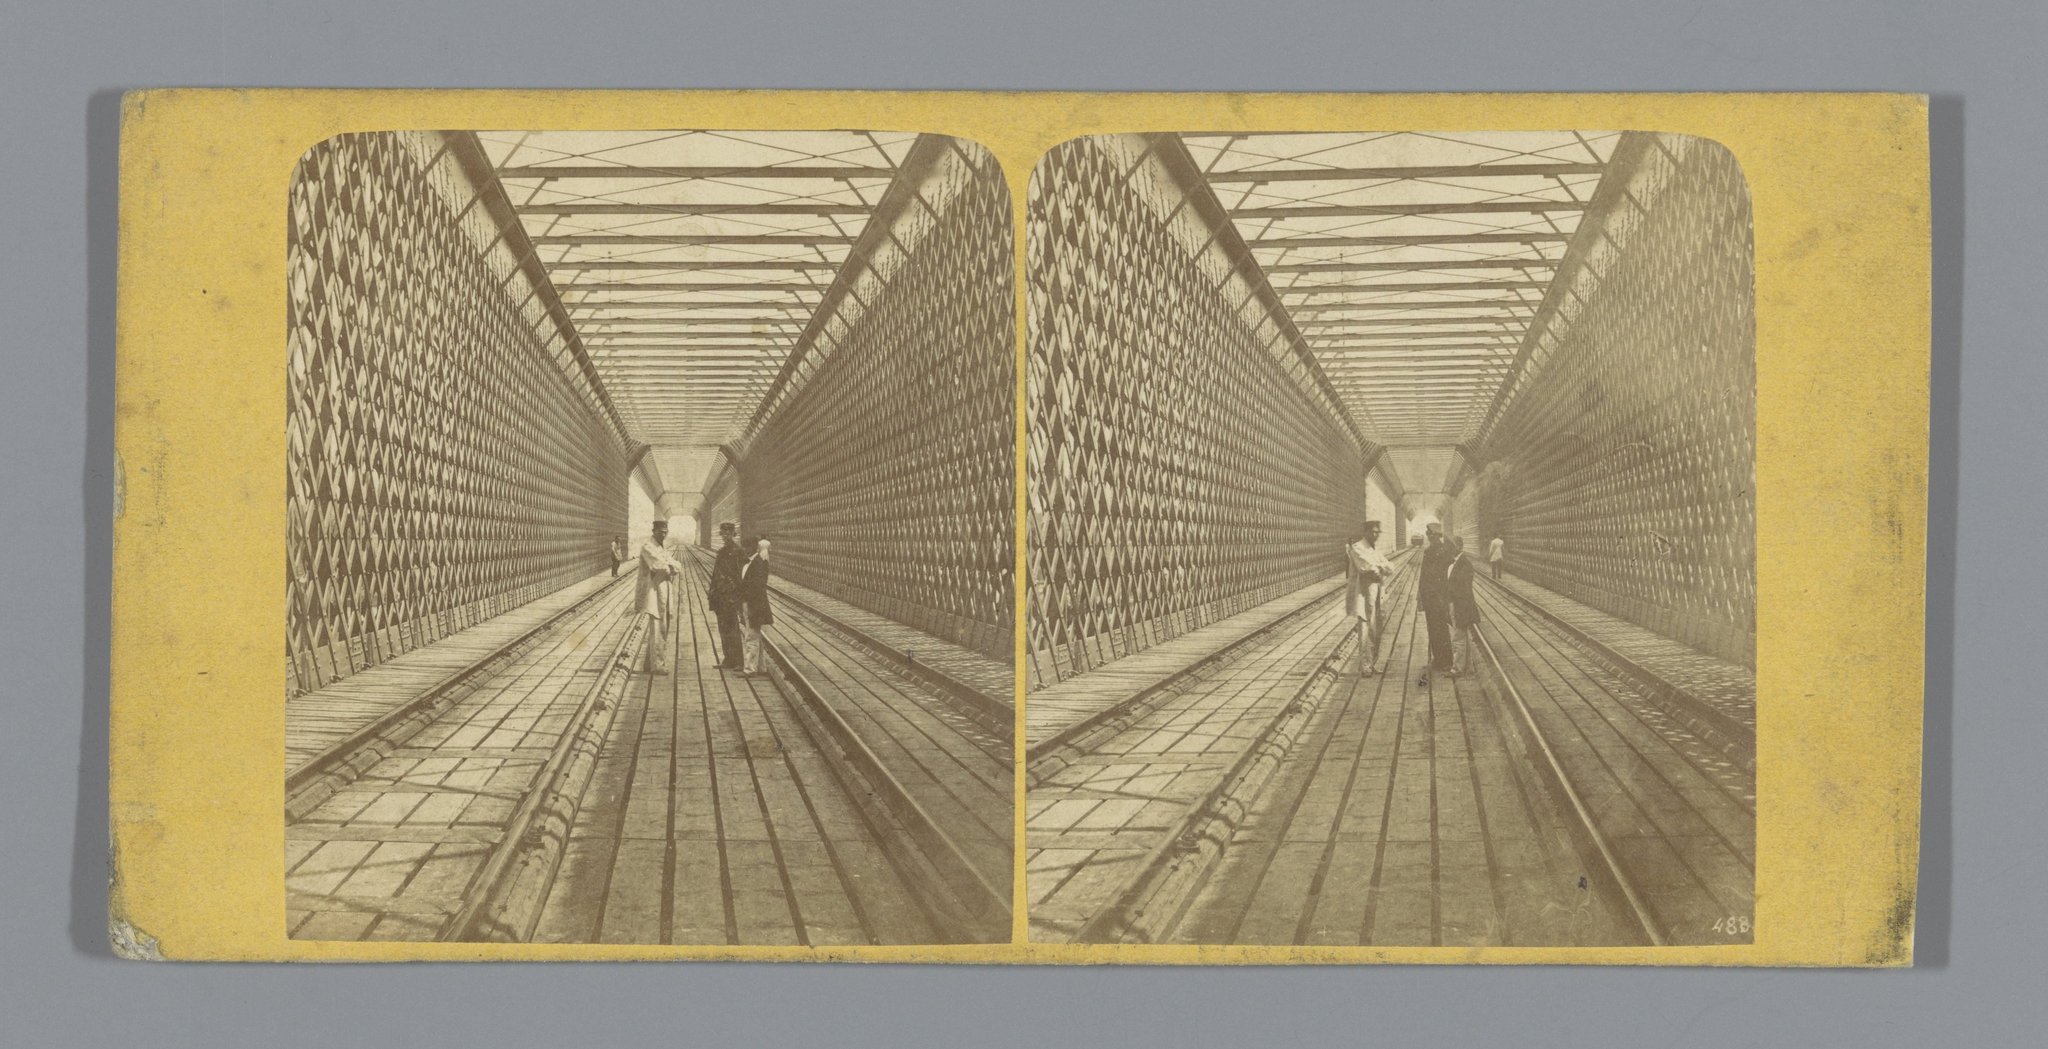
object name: stereograph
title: Cologne (Prusse). Le Pont de fer. Galerie du Chemin de fer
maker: Anonymous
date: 1860-1880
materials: cardboard, photographic support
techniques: albumen print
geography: dombrücke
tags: adult man, railway, tramway; rack railway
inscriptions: number: ‘488’